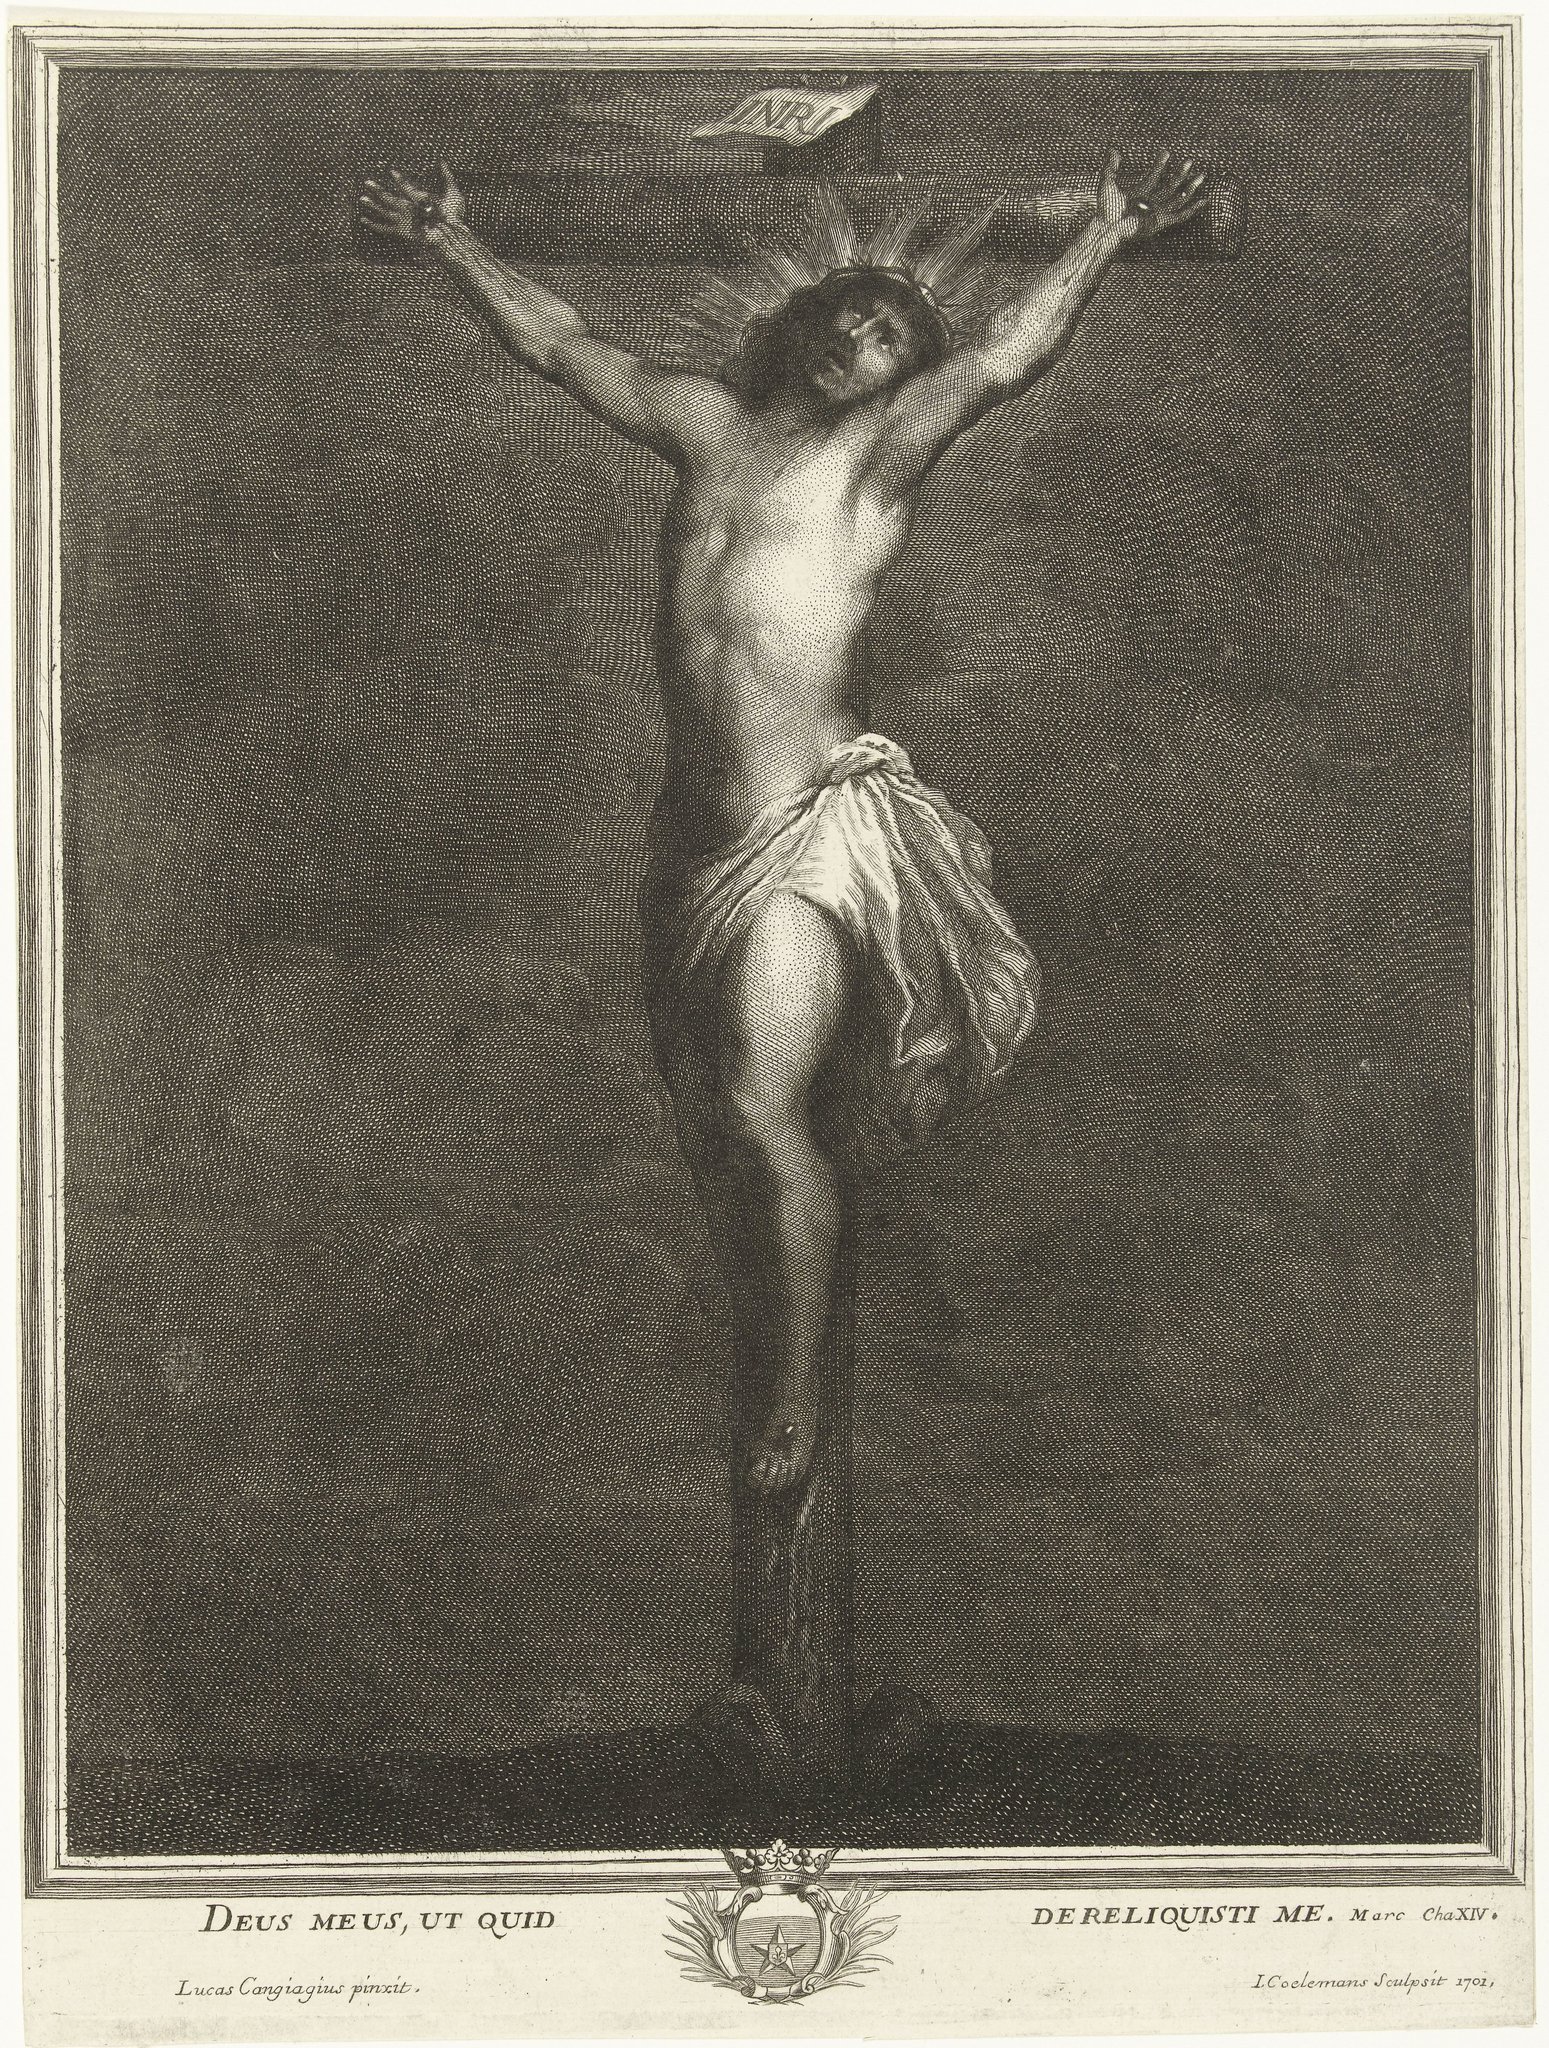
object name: print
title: Christus aan het kruis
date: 1701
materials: paper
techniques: engraving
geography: aix-en-provence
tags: christ triumphing (with crown, head usually upright)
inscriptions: collector's mark: Lugt 2228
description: Christus aan het kruis in de nacht, om zijn hoofd een stralenkrans. Onder de voorstelling een bijbelvers uit Marcus 14.